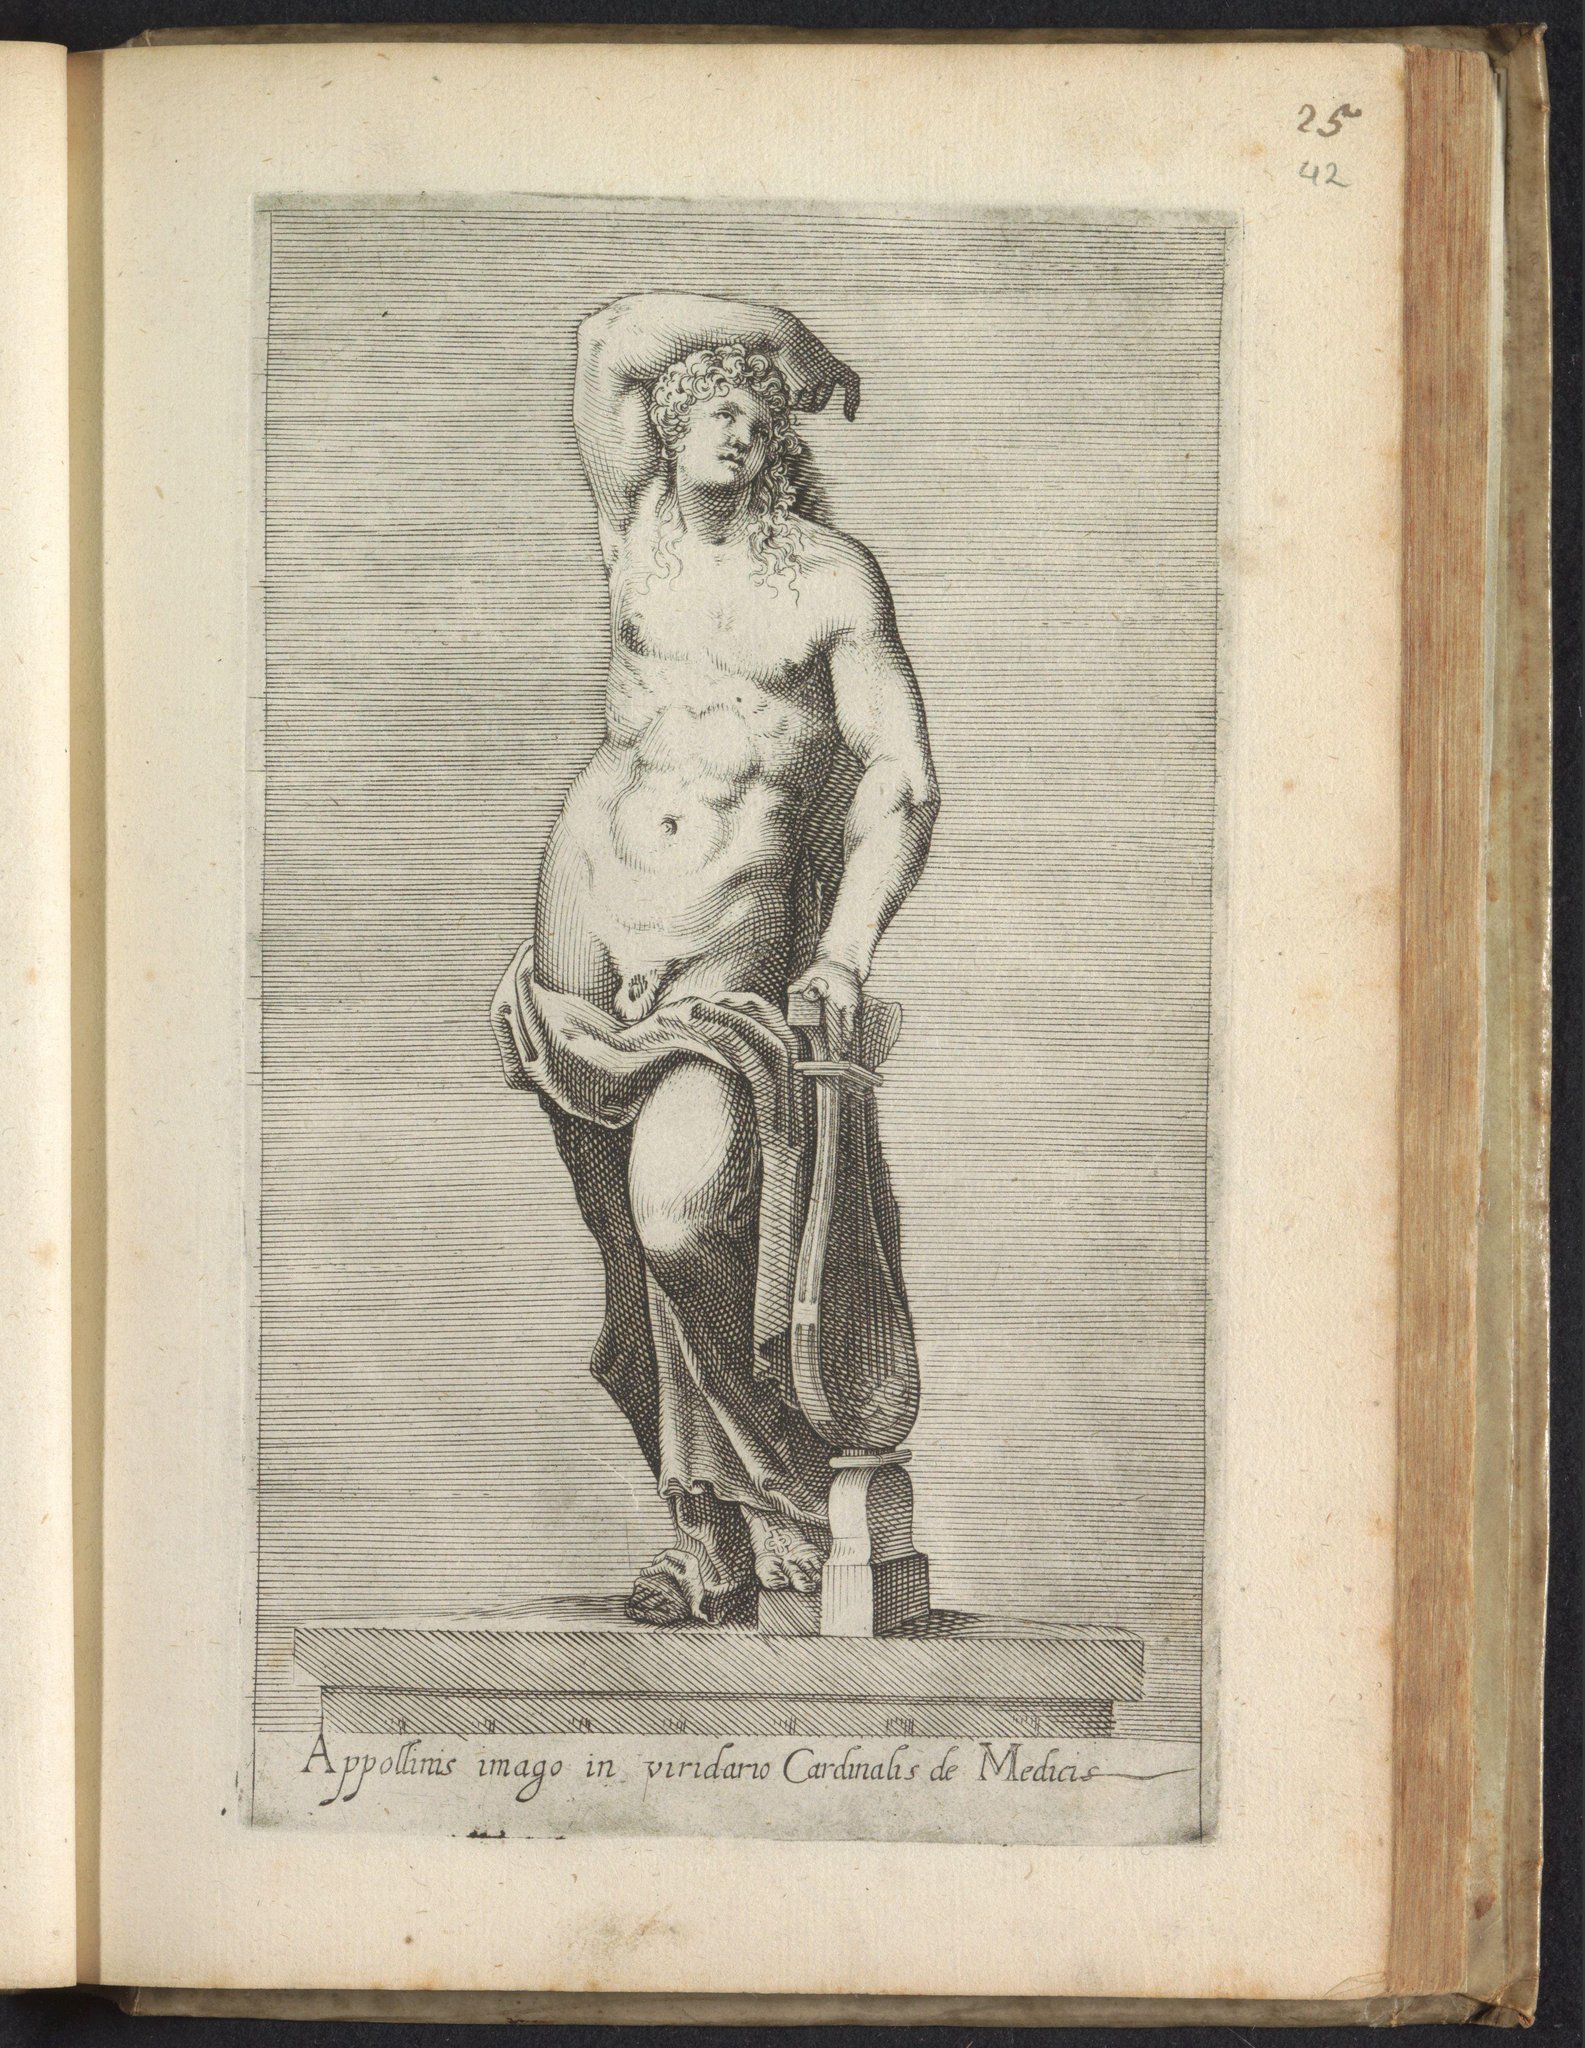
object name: album leaf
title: Antiquarum statuarum urbis Romae quae in publicis locis visuntur icones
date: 1584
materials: paper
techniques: engraving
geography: rome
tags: (story of) apollo (phoebus), piece of sculpture, reproduction of a piece of sculpture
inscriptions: number: ‘25’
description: Deze prent maakt deel uit van een set van 79 prenten (+ titelprent) met voorstellingen van antieke sculpturen in Rome.